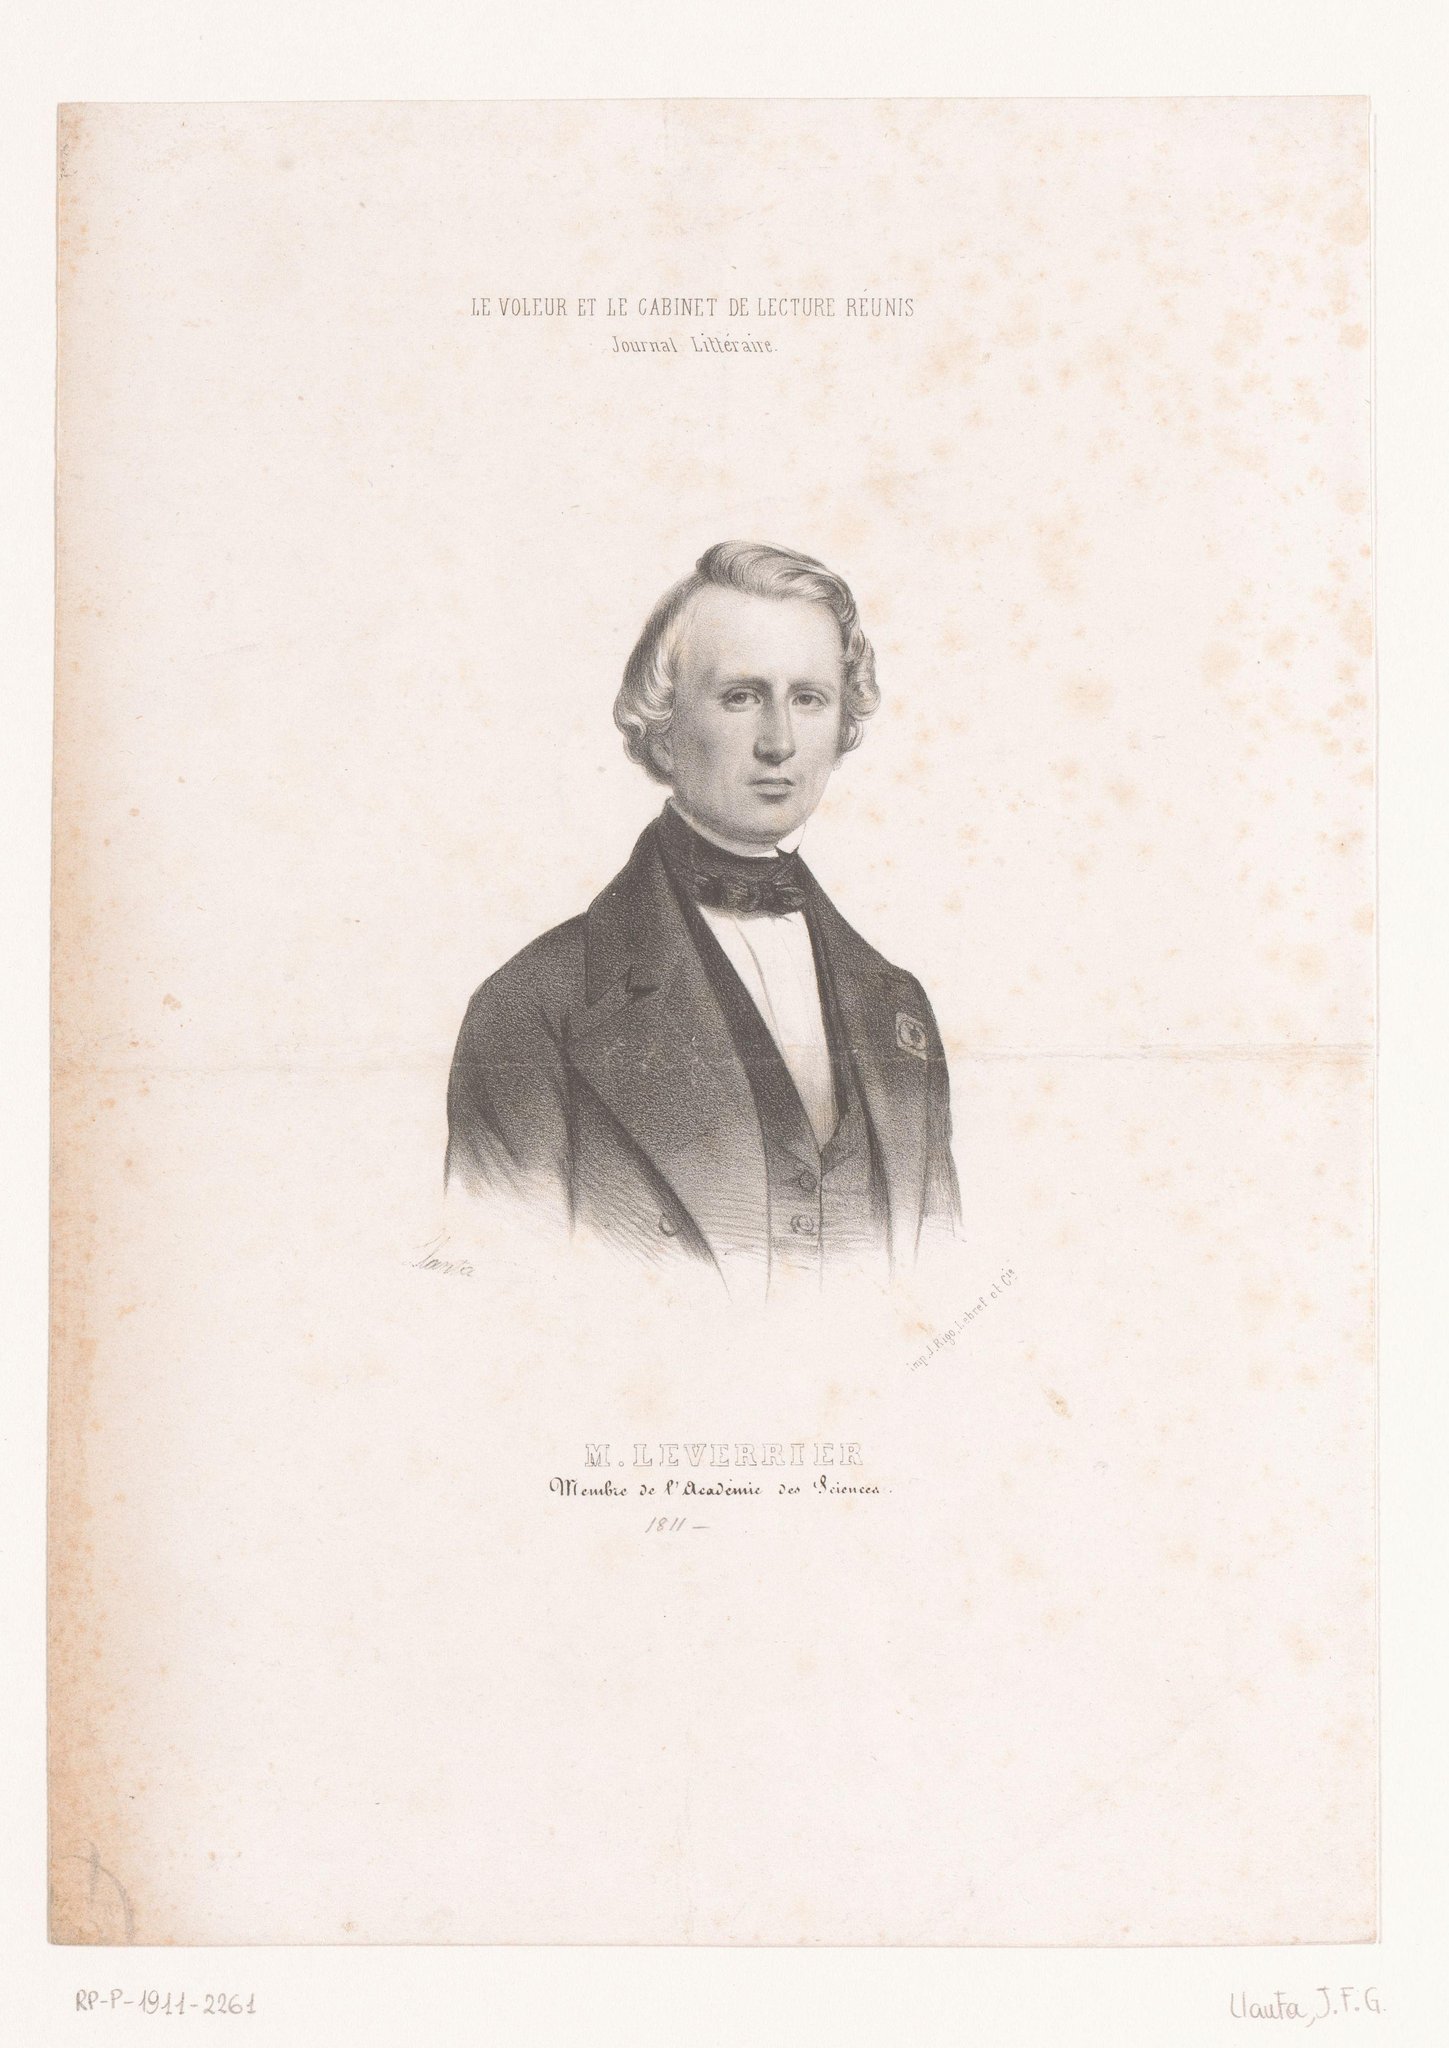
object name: print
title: M. Leverrier, membre de l'Academie des sciences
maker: jacques françois gauderique llanta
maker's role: print maker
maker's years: 1807-1864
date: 1842-1847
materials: paper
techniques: lithograph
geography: paris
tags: paris, politician, historical persons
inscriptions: collector's mark: Lugt 2228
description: Prent uit: Le Voleur et Le Cabinet de Lecture réunis. Journal littéraire, 1842-1856.